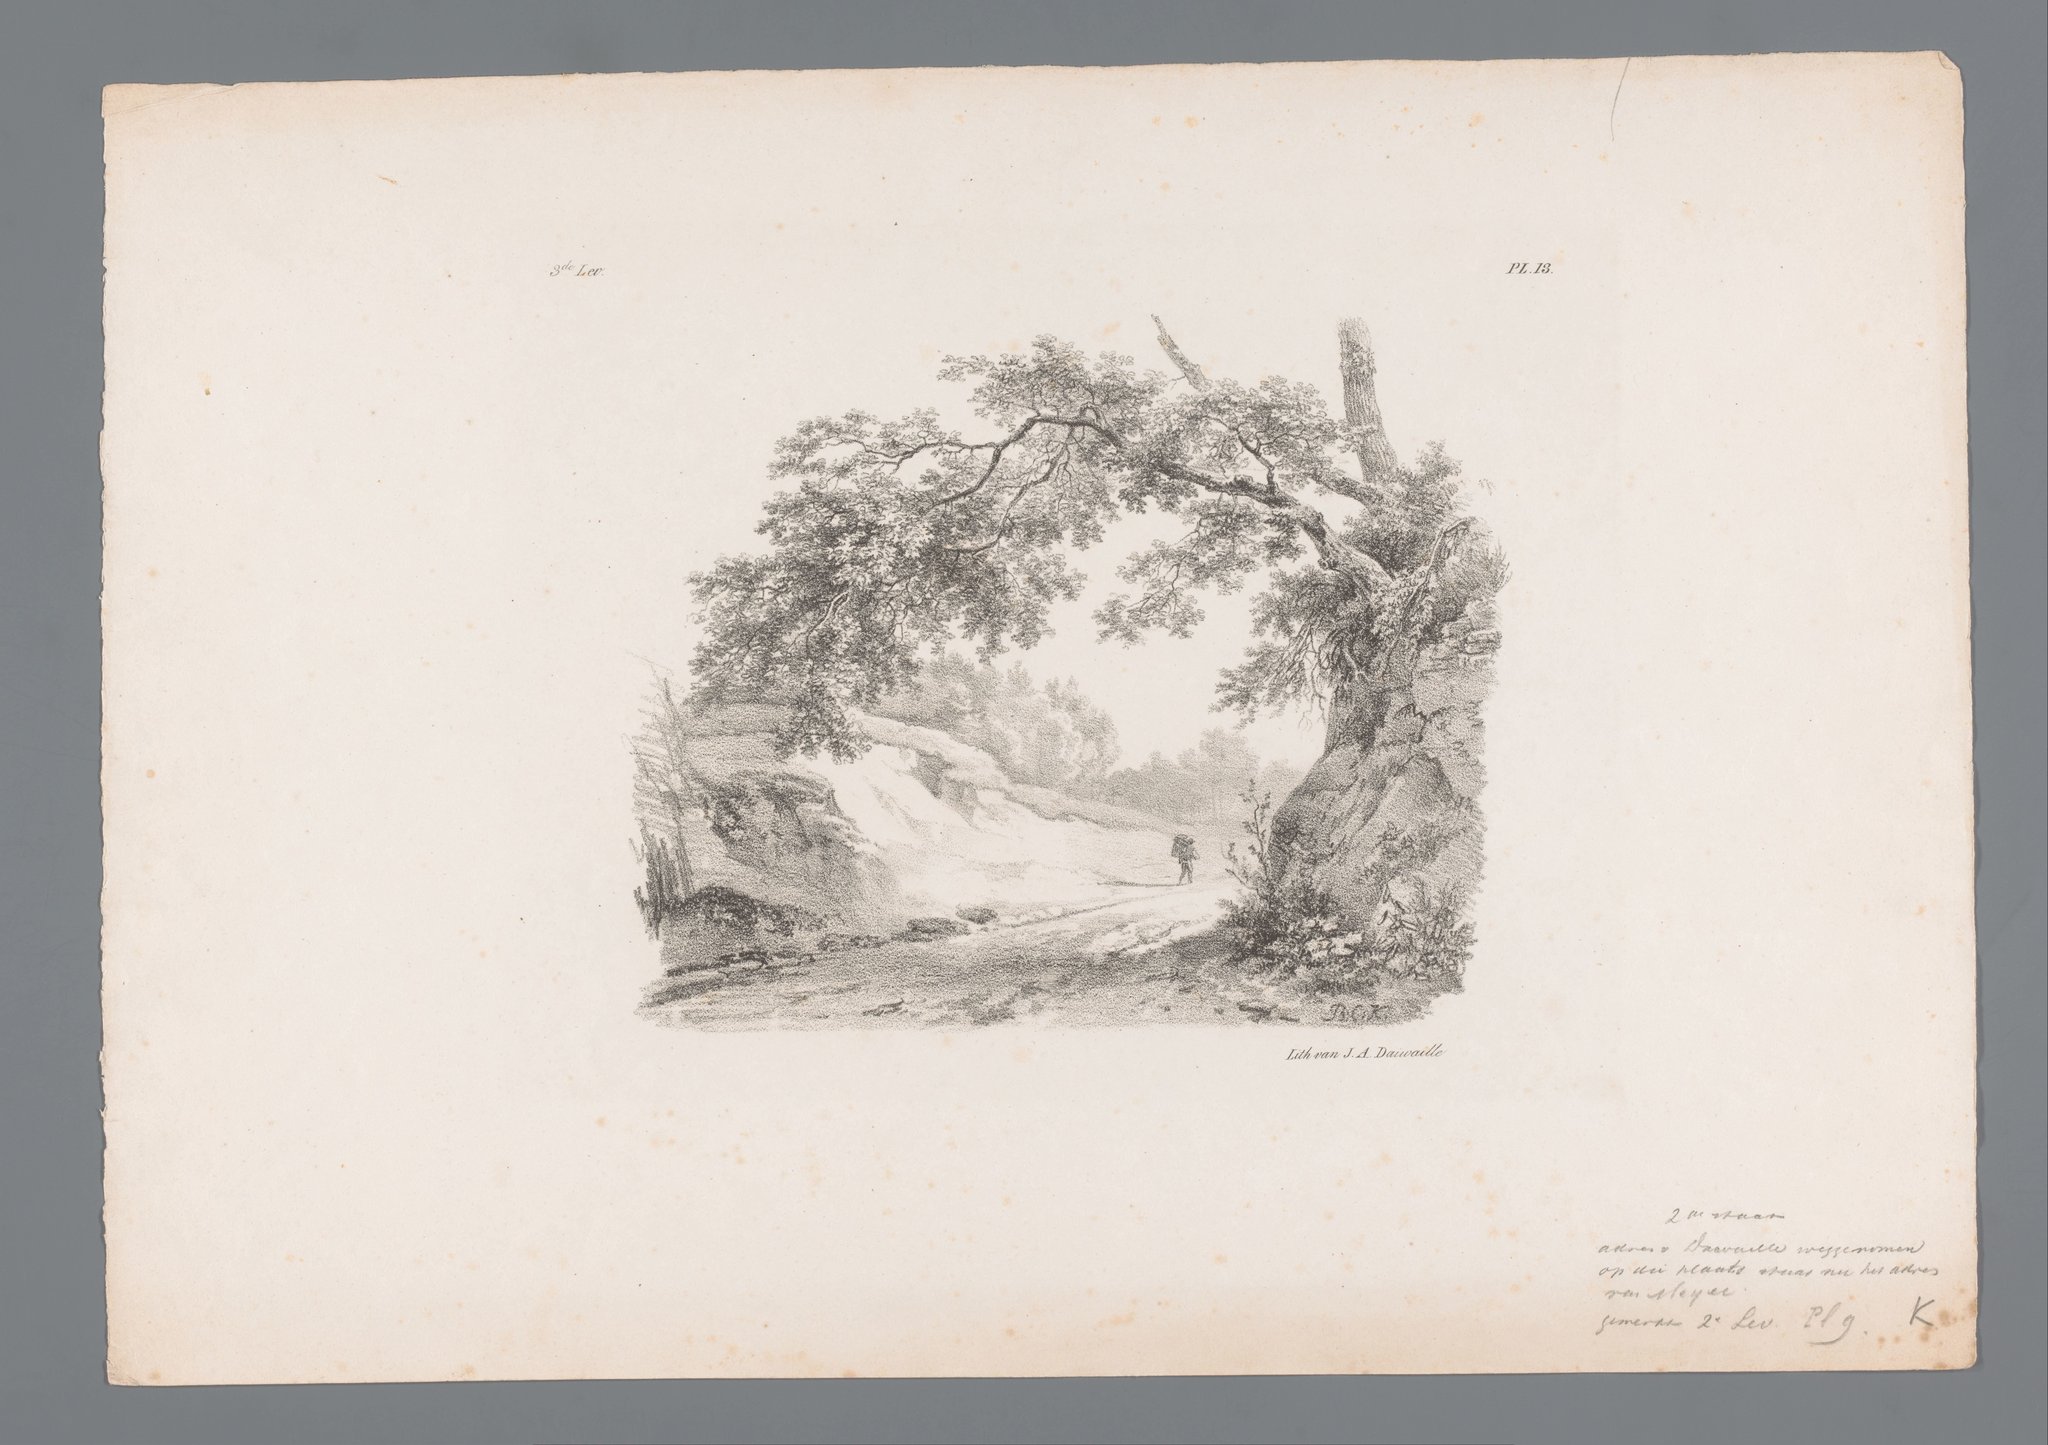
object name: print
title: Wandelaar op een zandweg in het bos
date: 1829-1830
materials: paper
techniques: lithograph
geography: amsterdam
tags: forest path or lane, 'en route', traveller under way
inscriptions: collector's mark: Lugt 2228, inscription: ‘2de staat / adres v. Dailwaille weggenomen / op die plaats staat nu het adres / van Meyer / gemerkt 2e Lev Pl. 9 K’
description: In 1829 en 1830 gaf Koekkoek, samen met Daiwaille, zes cahiers uit met ieder zes prenten getiteld Landschapstudiën. Deze werden gebruikt in het tekenonderwijs. Vijftien jaar later werd deze reeks, in een andere samenstelling nogmaals uitgegeven door Meyer en Comp in Amsterdam. Zie: De Bruyn Kops, 1963.